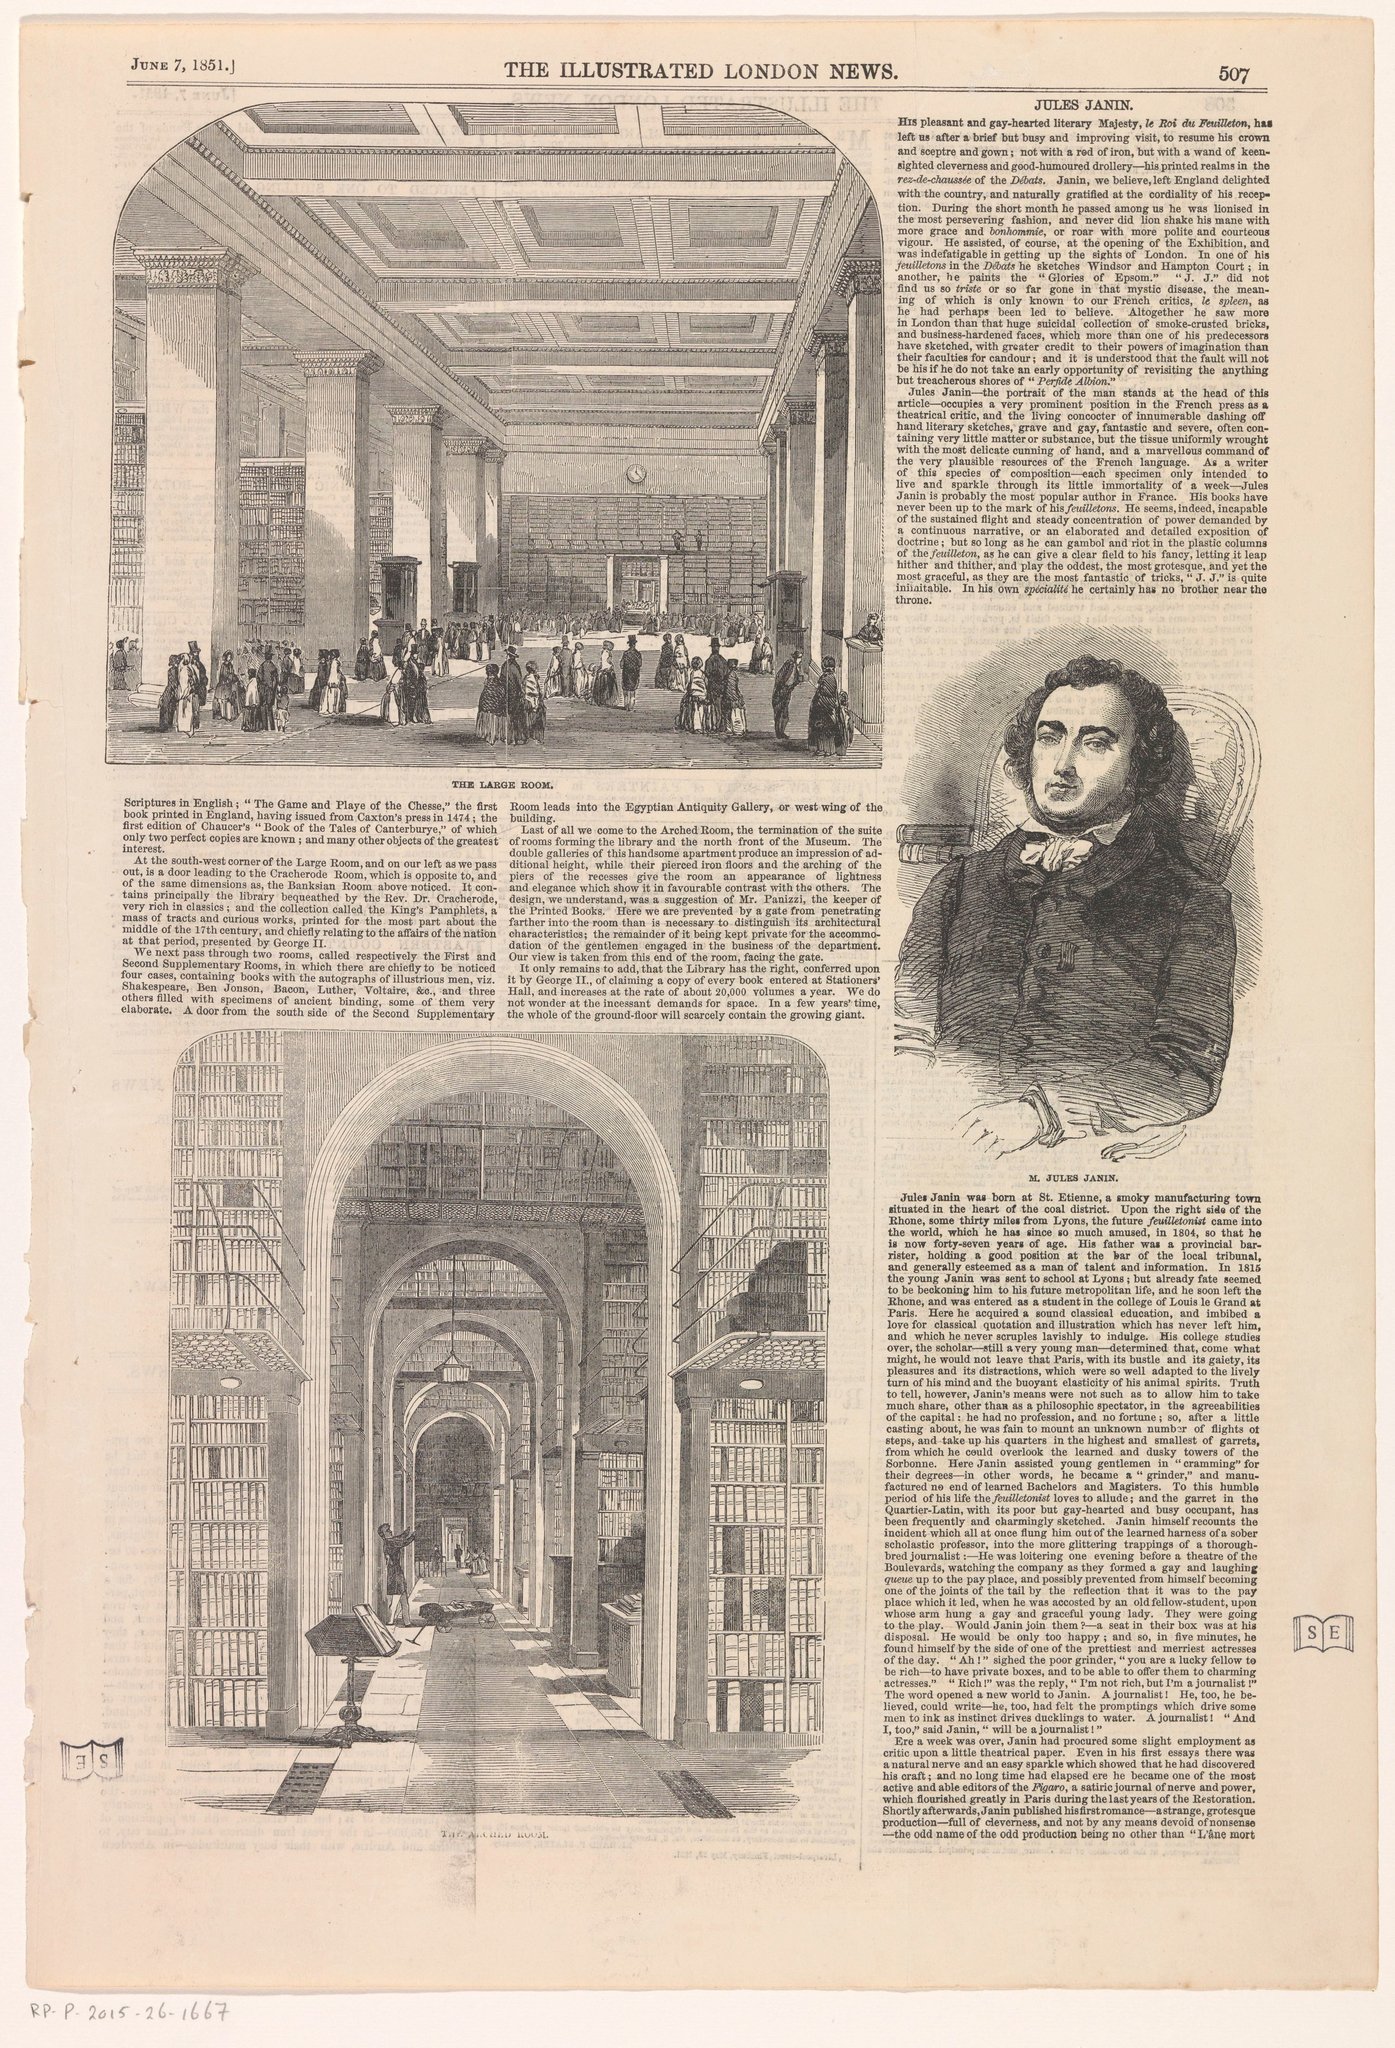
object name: print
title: The Large Room / The Arched Room / M. Jules Janin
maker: Anonymous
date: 1851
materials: paper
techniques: engraving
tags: jules gabriel janin, writer, poet, author, public library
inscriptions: collector's mark: Lugt 2228, collector's mark: Lugt 4779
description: Tekstblad met drie illustraties. Twee prenten tonen de bibliotheek van het British Museum: 'The Large Room' en 'The Arched Room'. De derde prent toont het portret van de Franse schrijver Jules Janin.